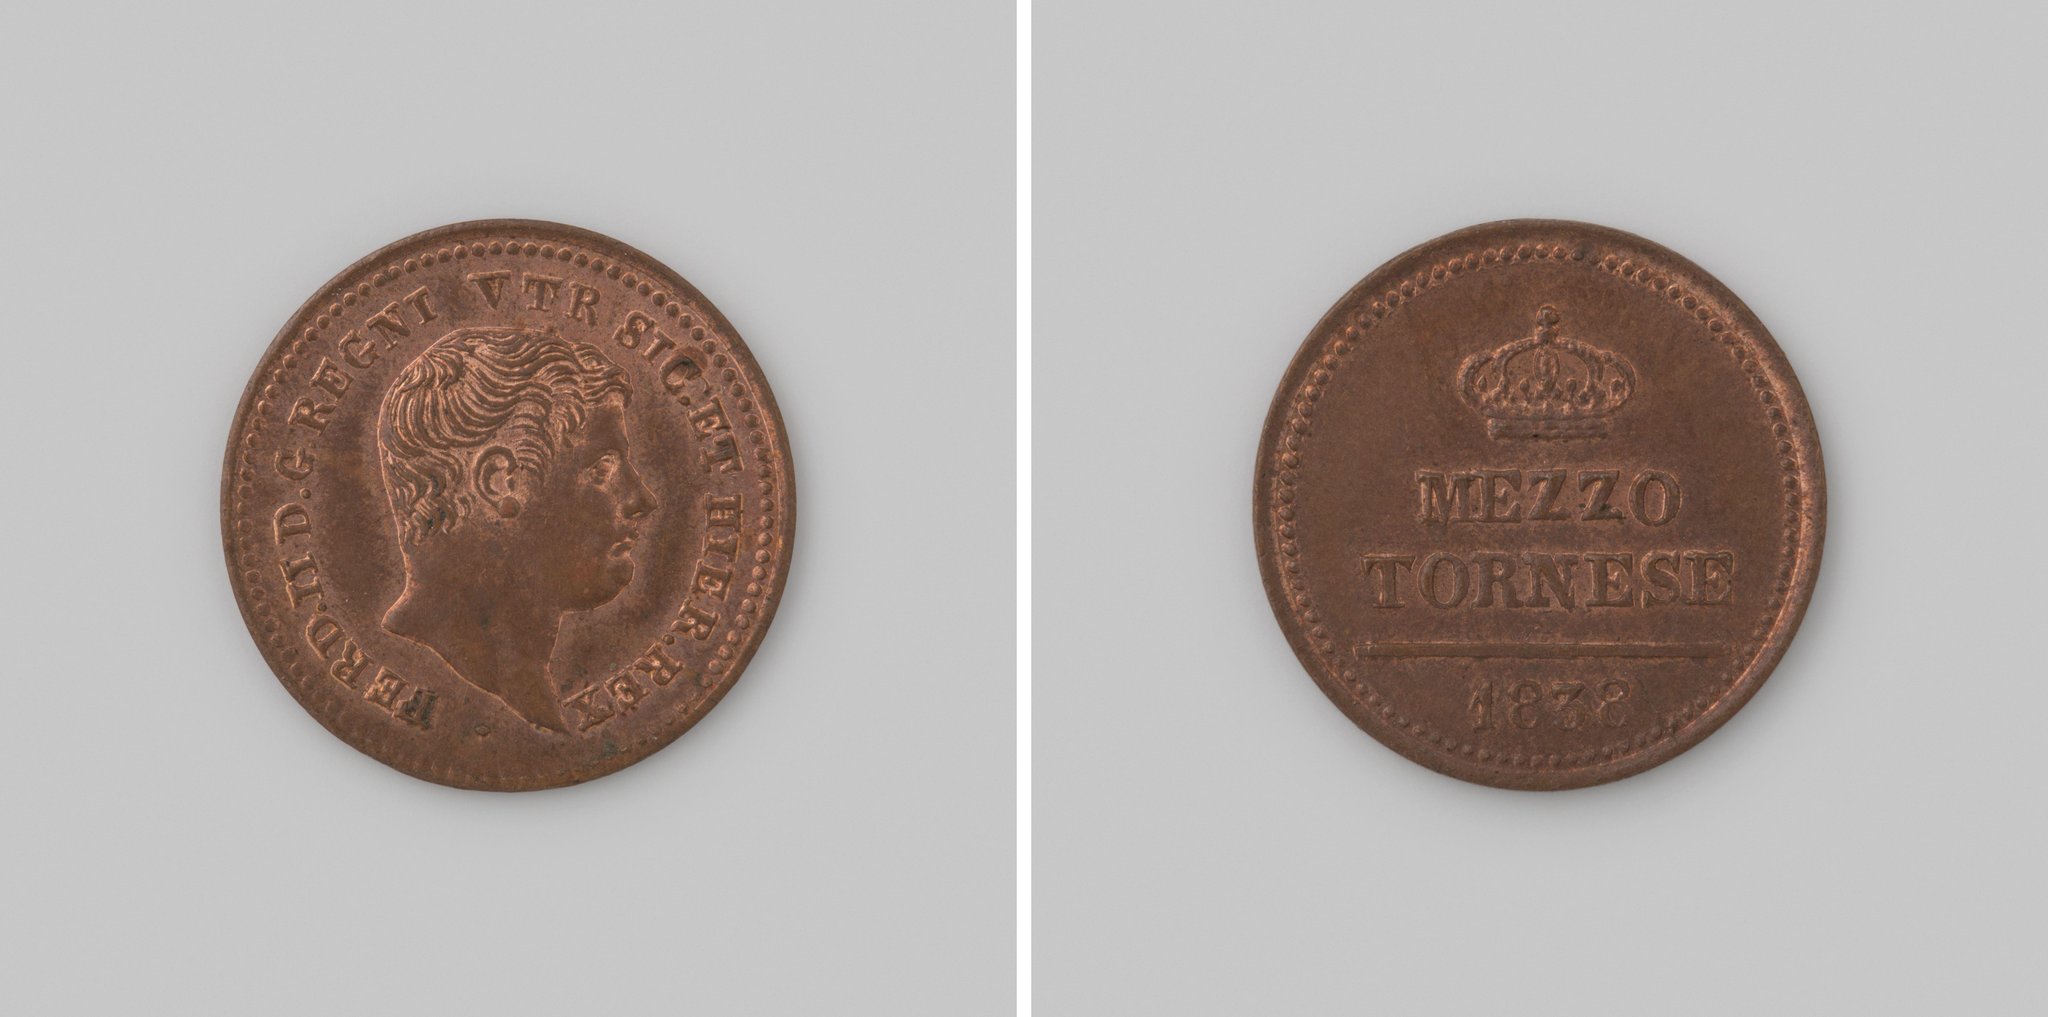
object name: coin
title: ½ tornese uit het koninkrijk Napels van de beide Siciliën van Ferdinando II, 1838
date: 1838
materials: copper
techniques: striking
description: Koperen munt. Voorzijde: hoofd naar rechts. Keerzijde: kroon, waaronder in twee regels waarde-aanduiding. Jaartal in afsnede onderaan. Gladde rand.